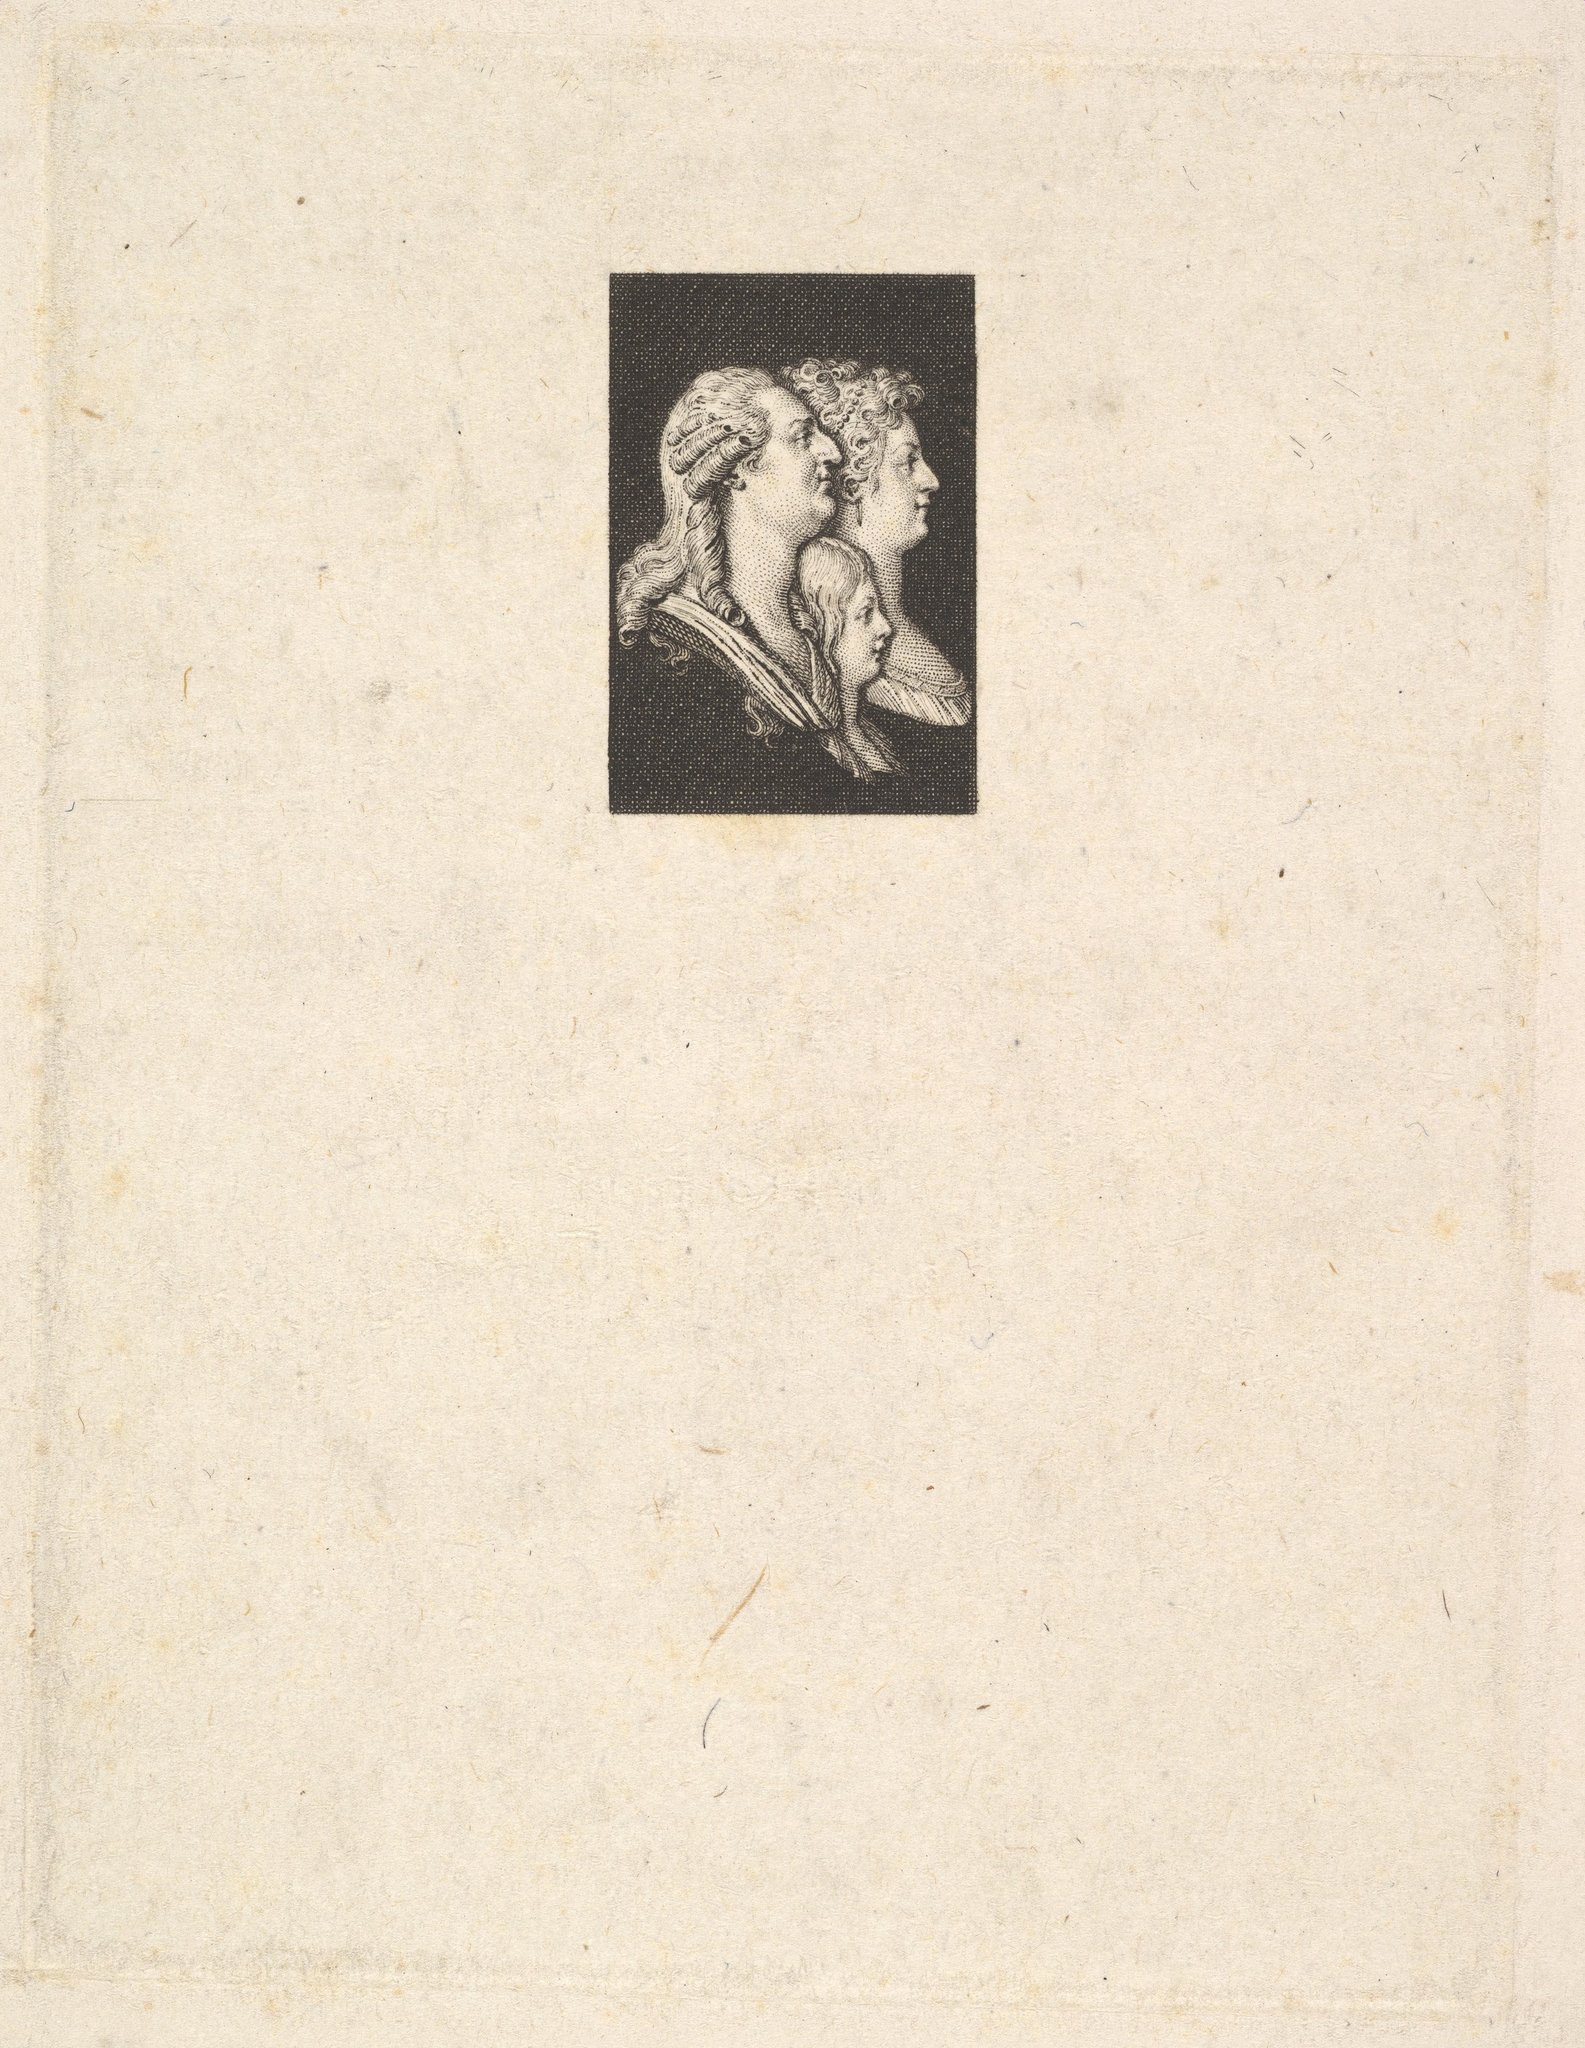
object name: print ornament architecture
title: Portrait of Louis XVI, Marie Antoinette and The Dauphin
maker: augustin de saint-aubin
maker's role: artist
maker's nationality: french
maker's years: 1736-1807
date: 1791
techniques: engraving, etching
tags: girls,men,profiles,women